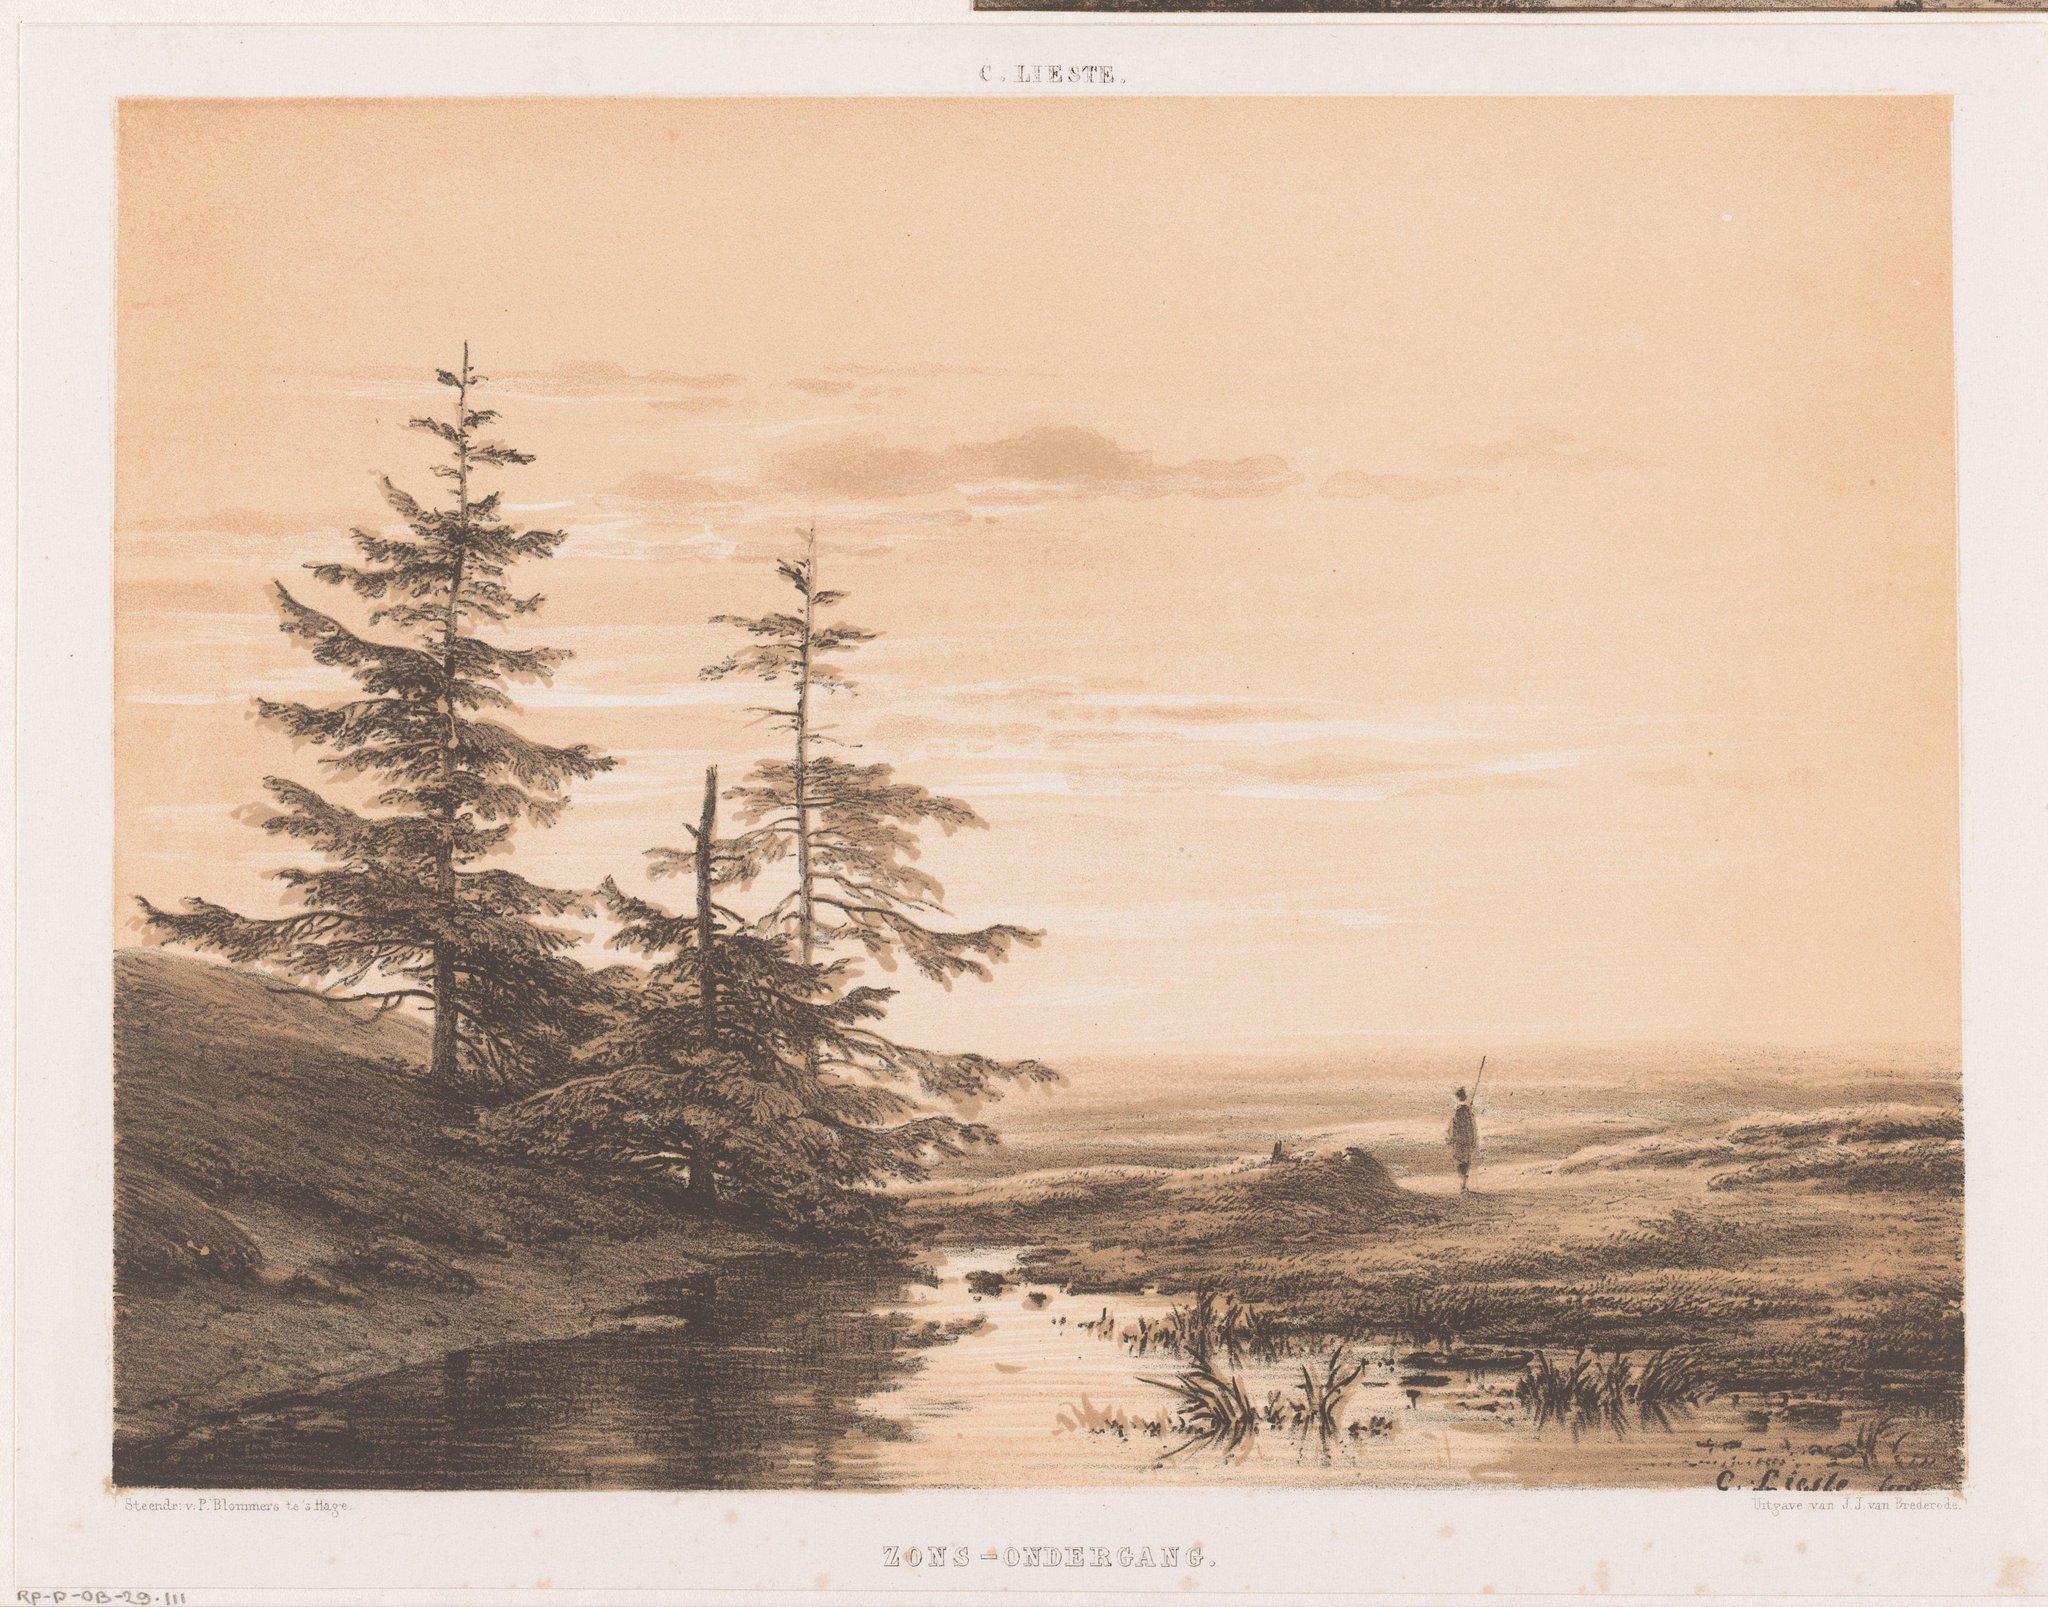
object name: print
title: Landschap met zonsondergang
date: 1847-1883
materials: paper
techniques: tone lithography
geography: the hague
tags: sunset, 'en route', traveller under way, trees: pine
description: Een wandelaar kijkt naar een ondergaande zon. Links drie dennenbomen.